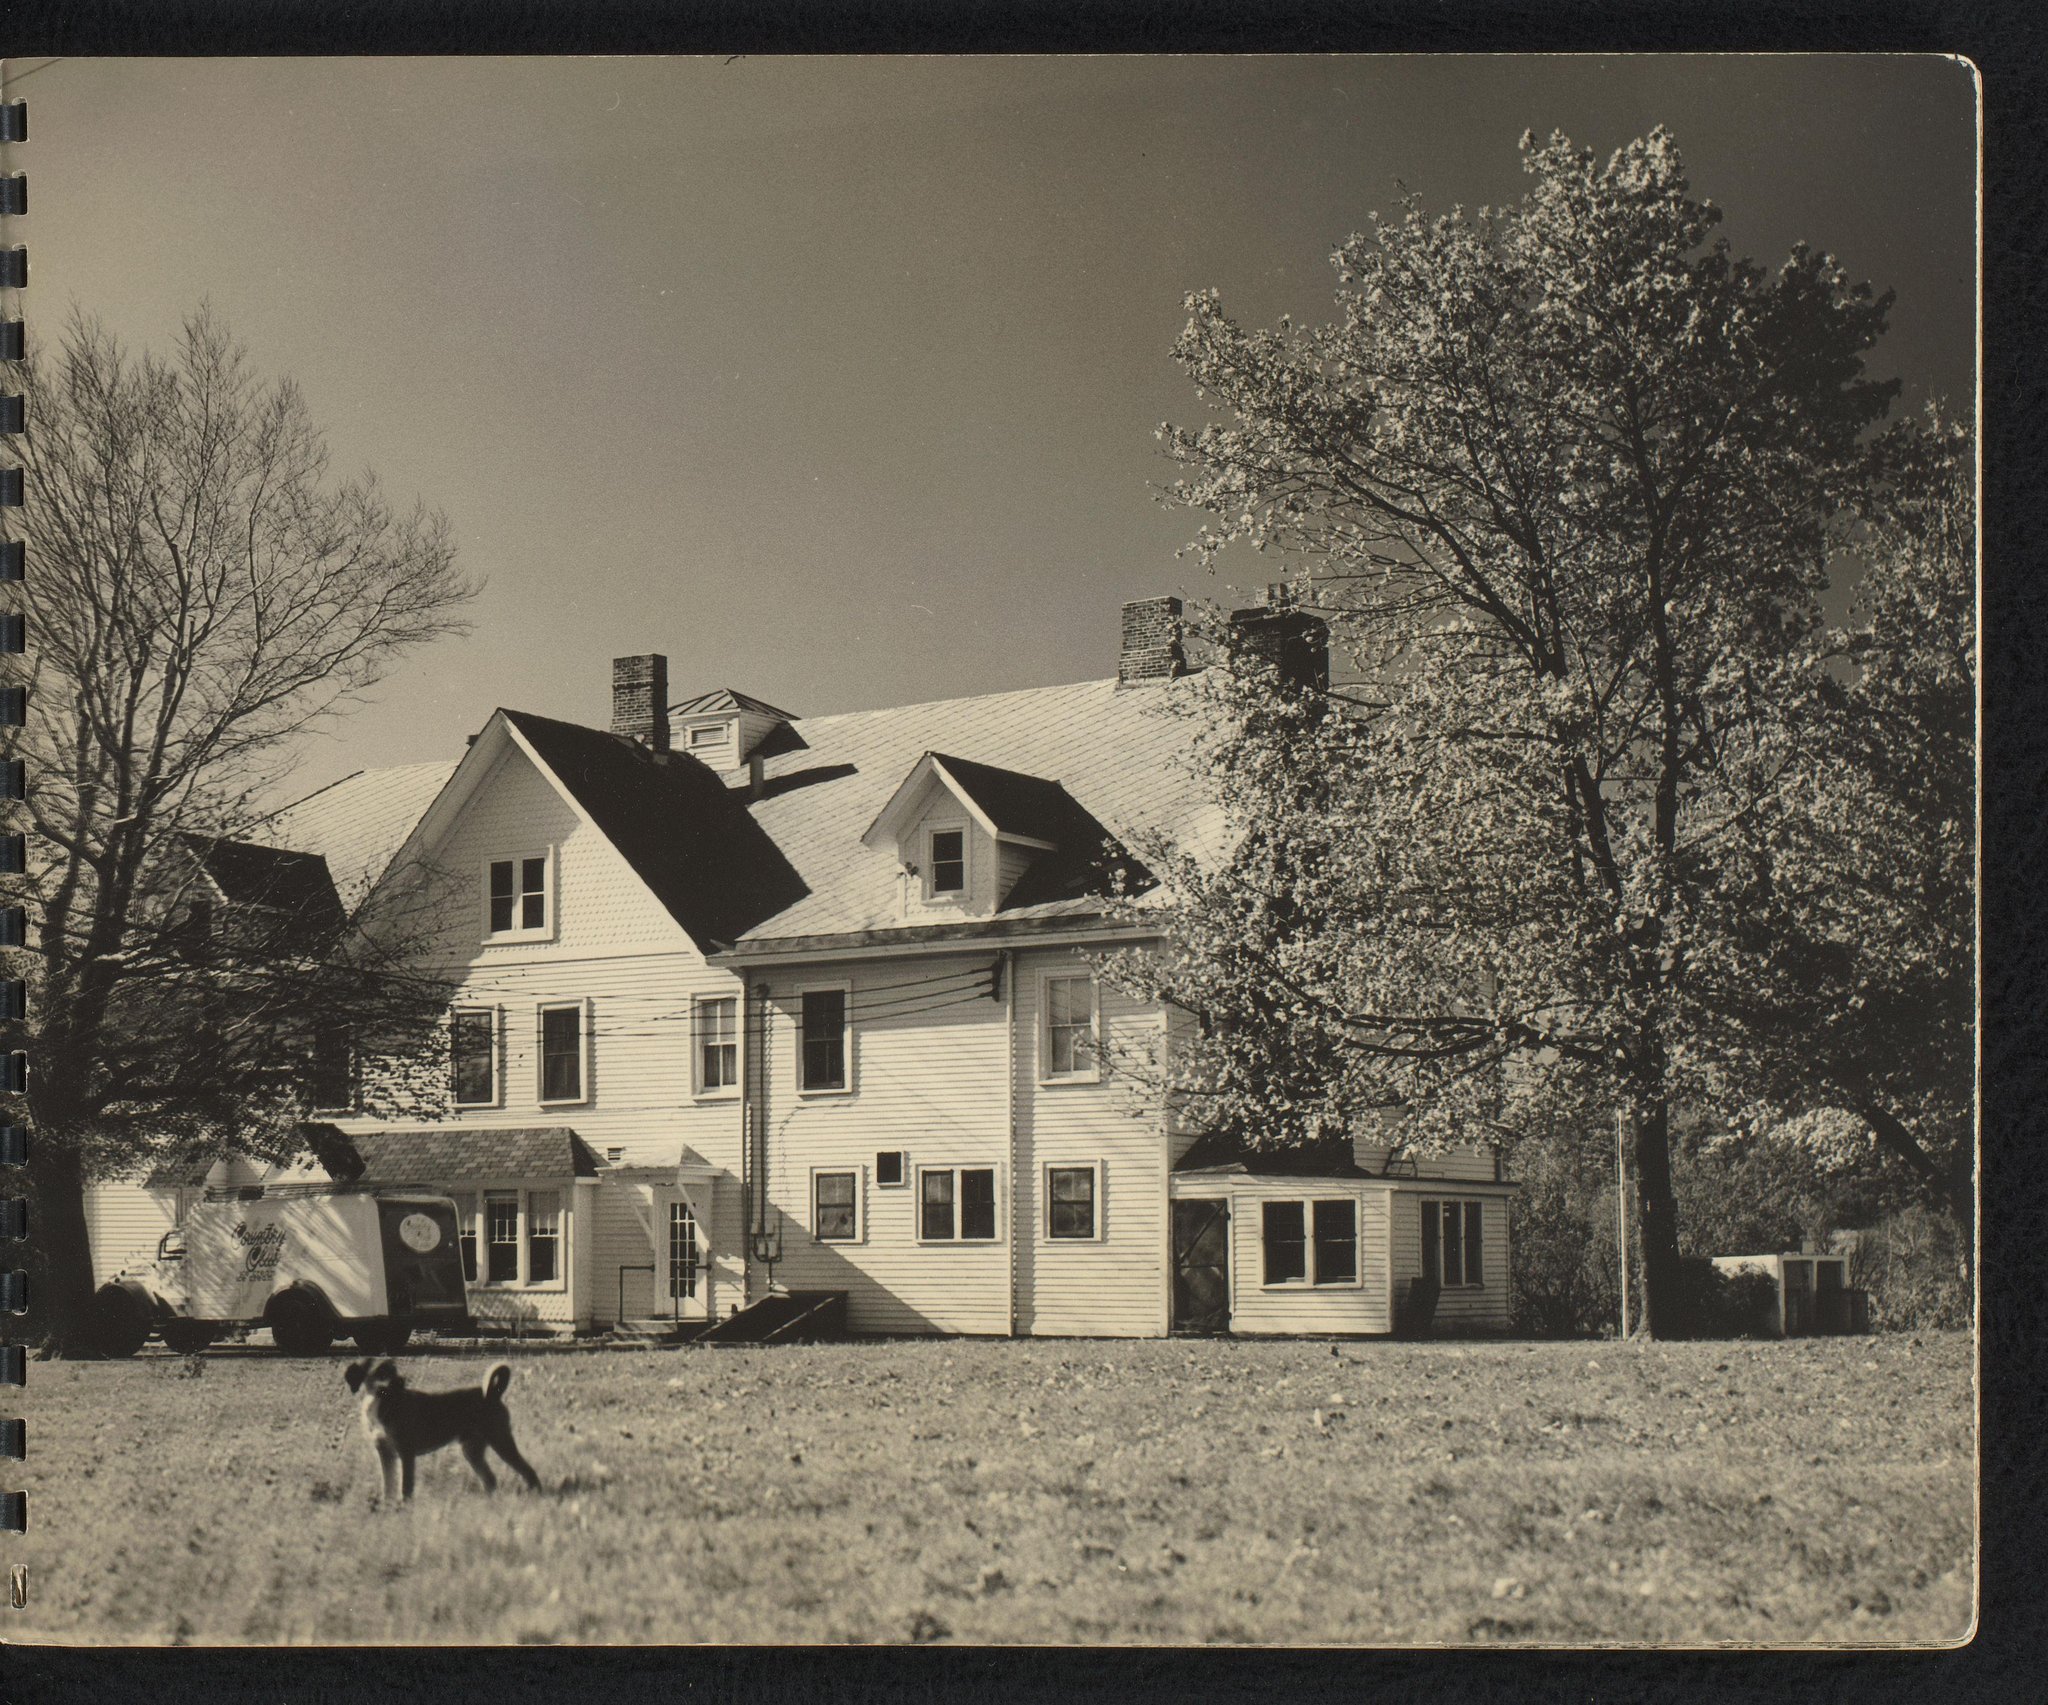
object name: photograph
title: Hoofdgebouw (‘Main Building’)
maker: Anonymous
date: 1950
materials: paper, photographic support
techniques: gelatin silver print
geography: new york city